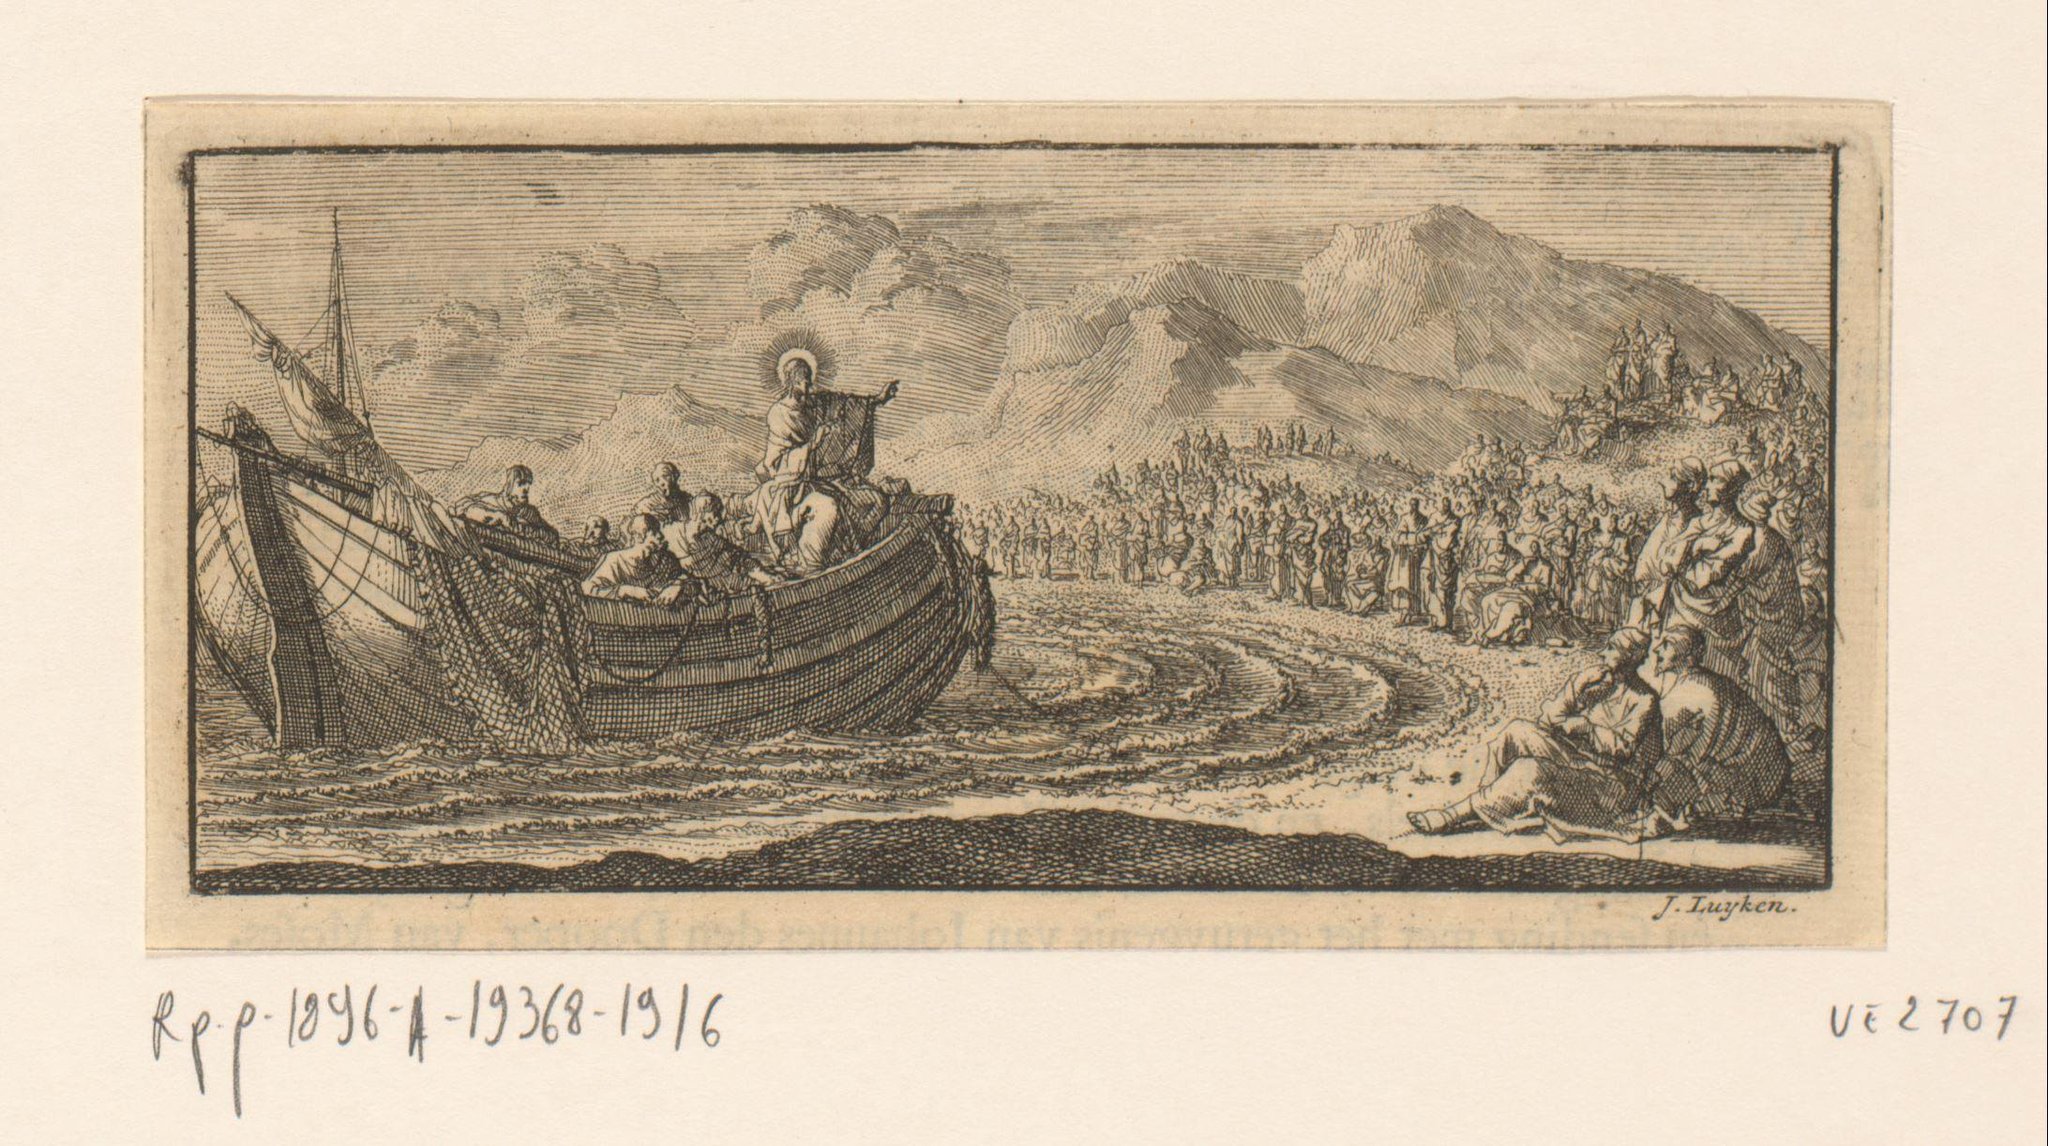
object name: book illustration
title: Jezus predikt vanuit de boot van Petrus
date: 1700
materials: paper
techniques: etching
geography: amsterdam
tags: christ preaching from a boat, christ in peter's boat preaching to the people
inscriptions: collector's mark: Lugt 2228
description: Christus predikt vanop de boot van Petrus op het meer van Gennesaret, rondom hem zijn leerlingen. Aan de oever van het meer een grote groep toehoorders die naar zijn preek luisteren.